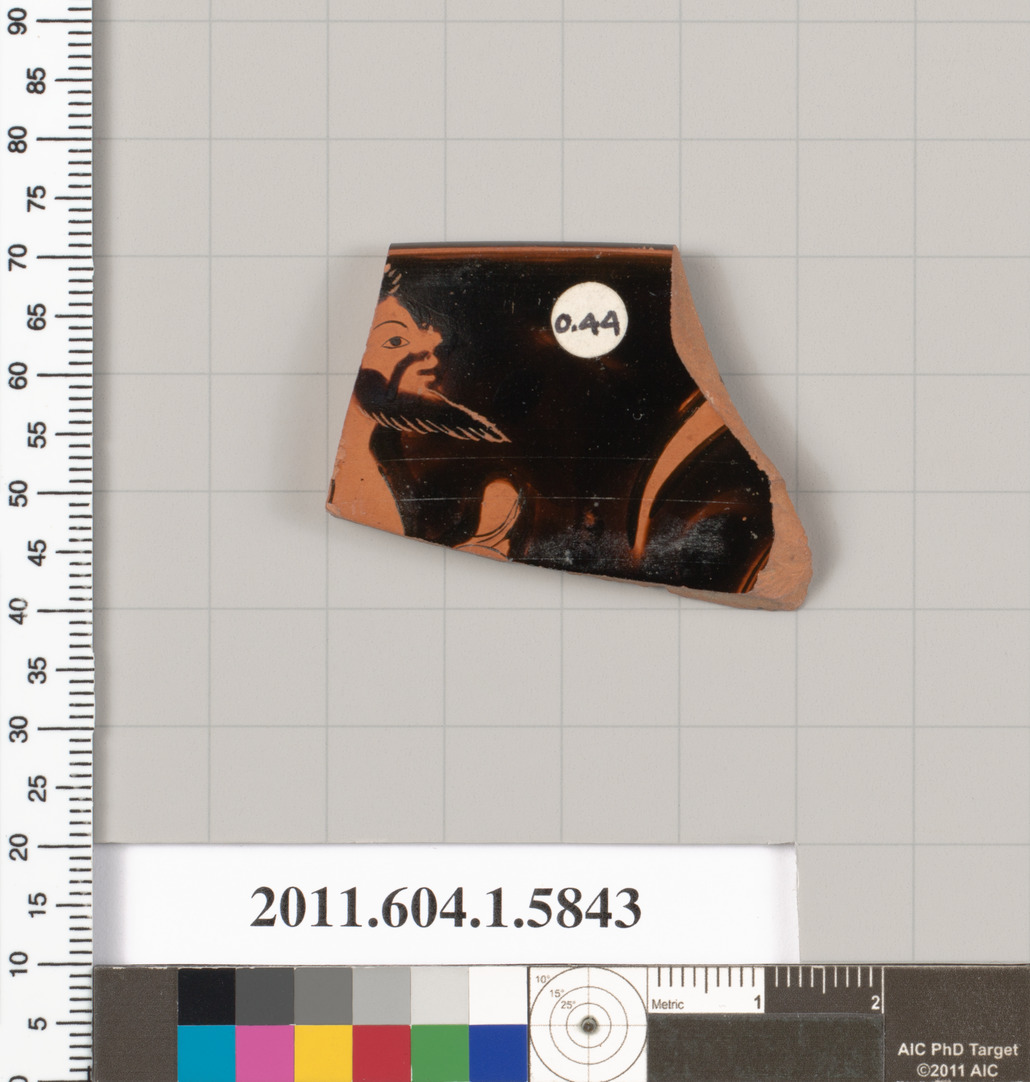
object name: kylix fragment, eye cup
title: Terracotta rim fragment of a kylix: eye-cup (drinking cup)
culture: greek, attic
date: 433-567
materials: terracotta